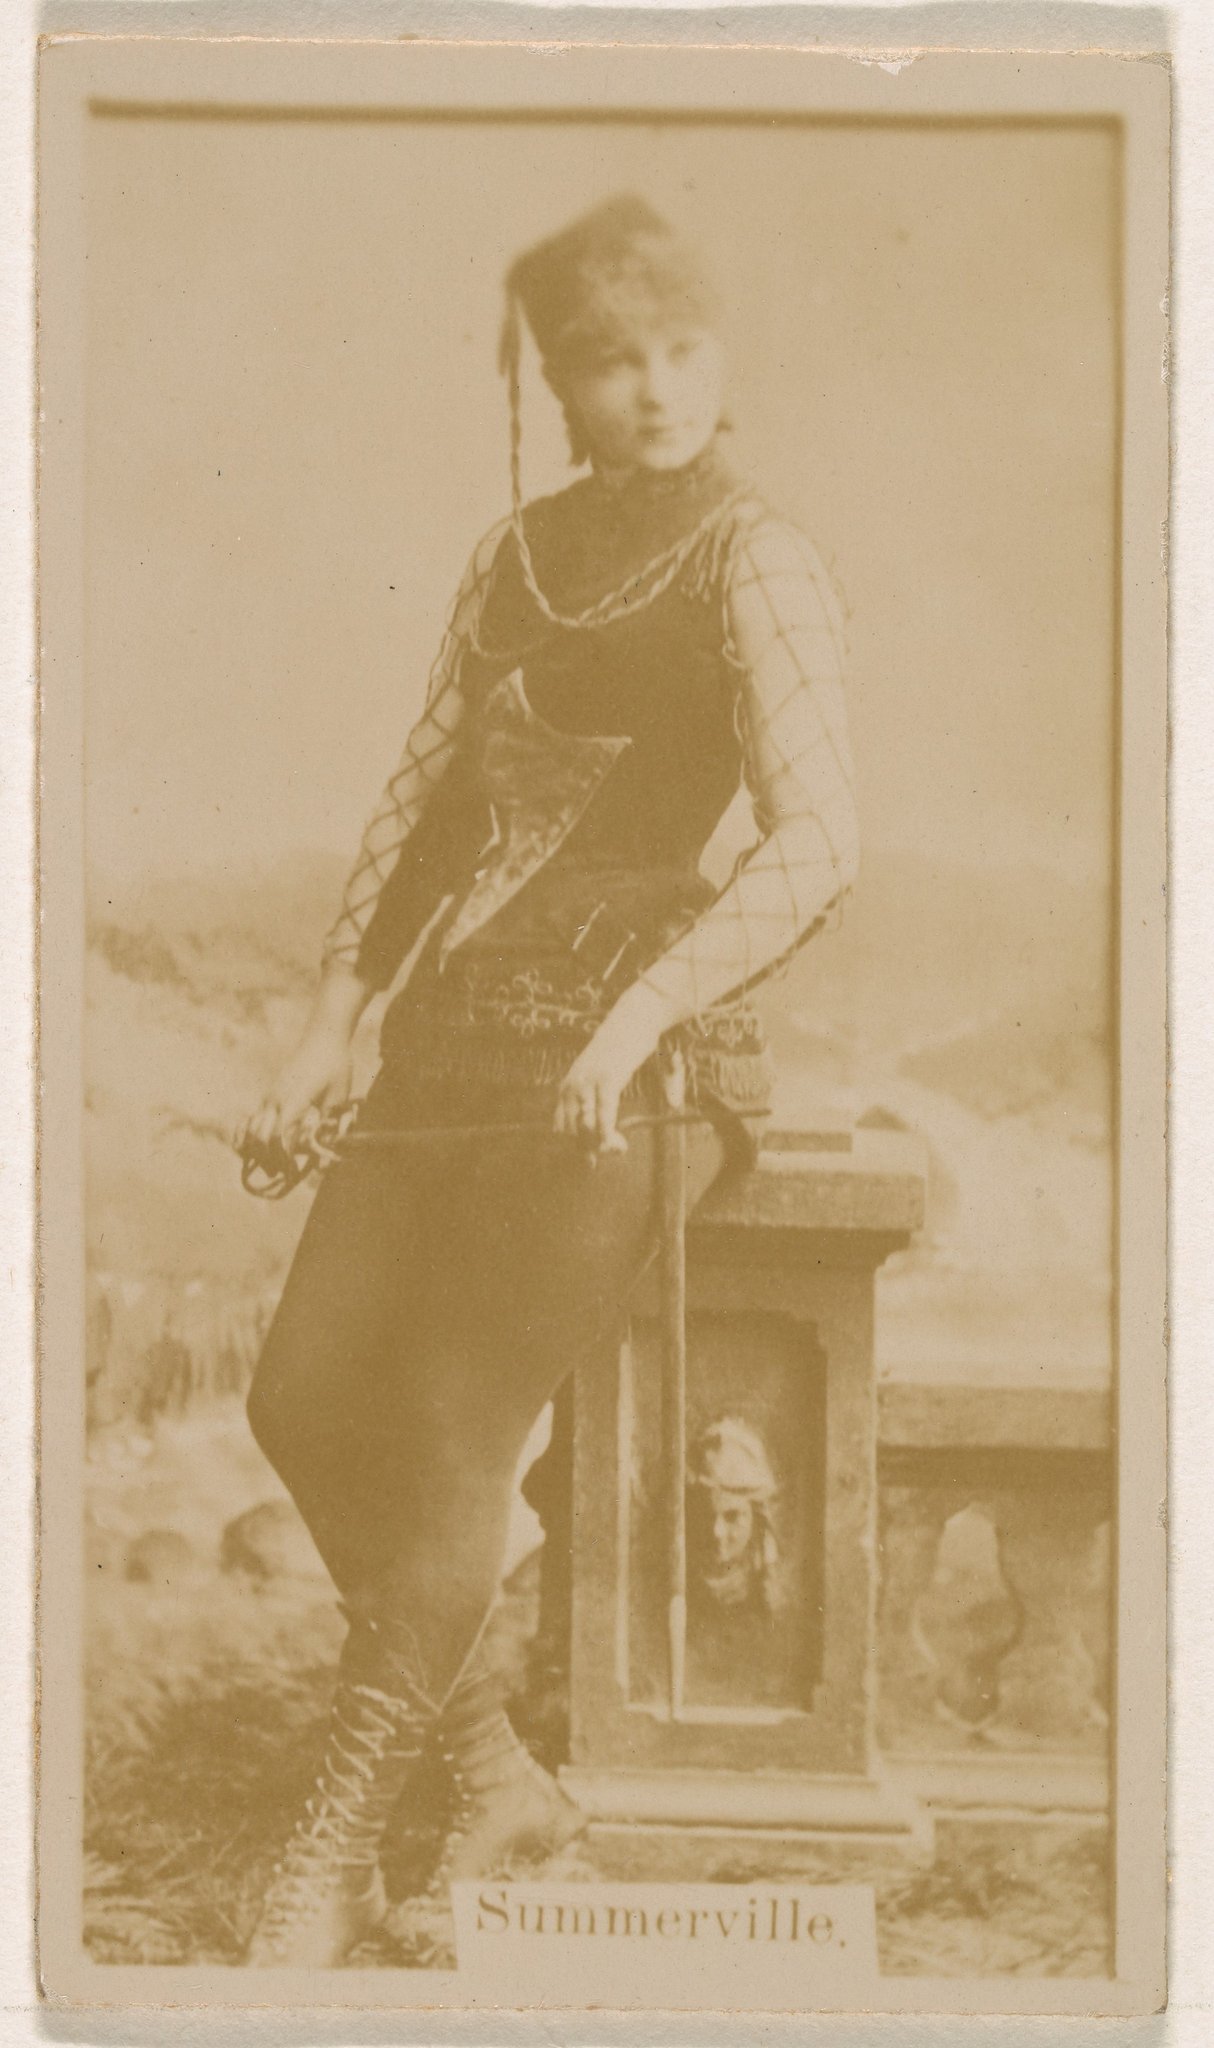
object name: photograph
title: Miss Annie Summerville, from the Actresses series (N245) issued by Kinney Brothers to promote Sweet Caporal Cigarettes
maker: kinney brothers tobacco company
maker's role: publisher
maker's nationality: american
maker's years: 1869-2011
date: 1890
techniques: albumen silver print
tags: portraits,women,actresses